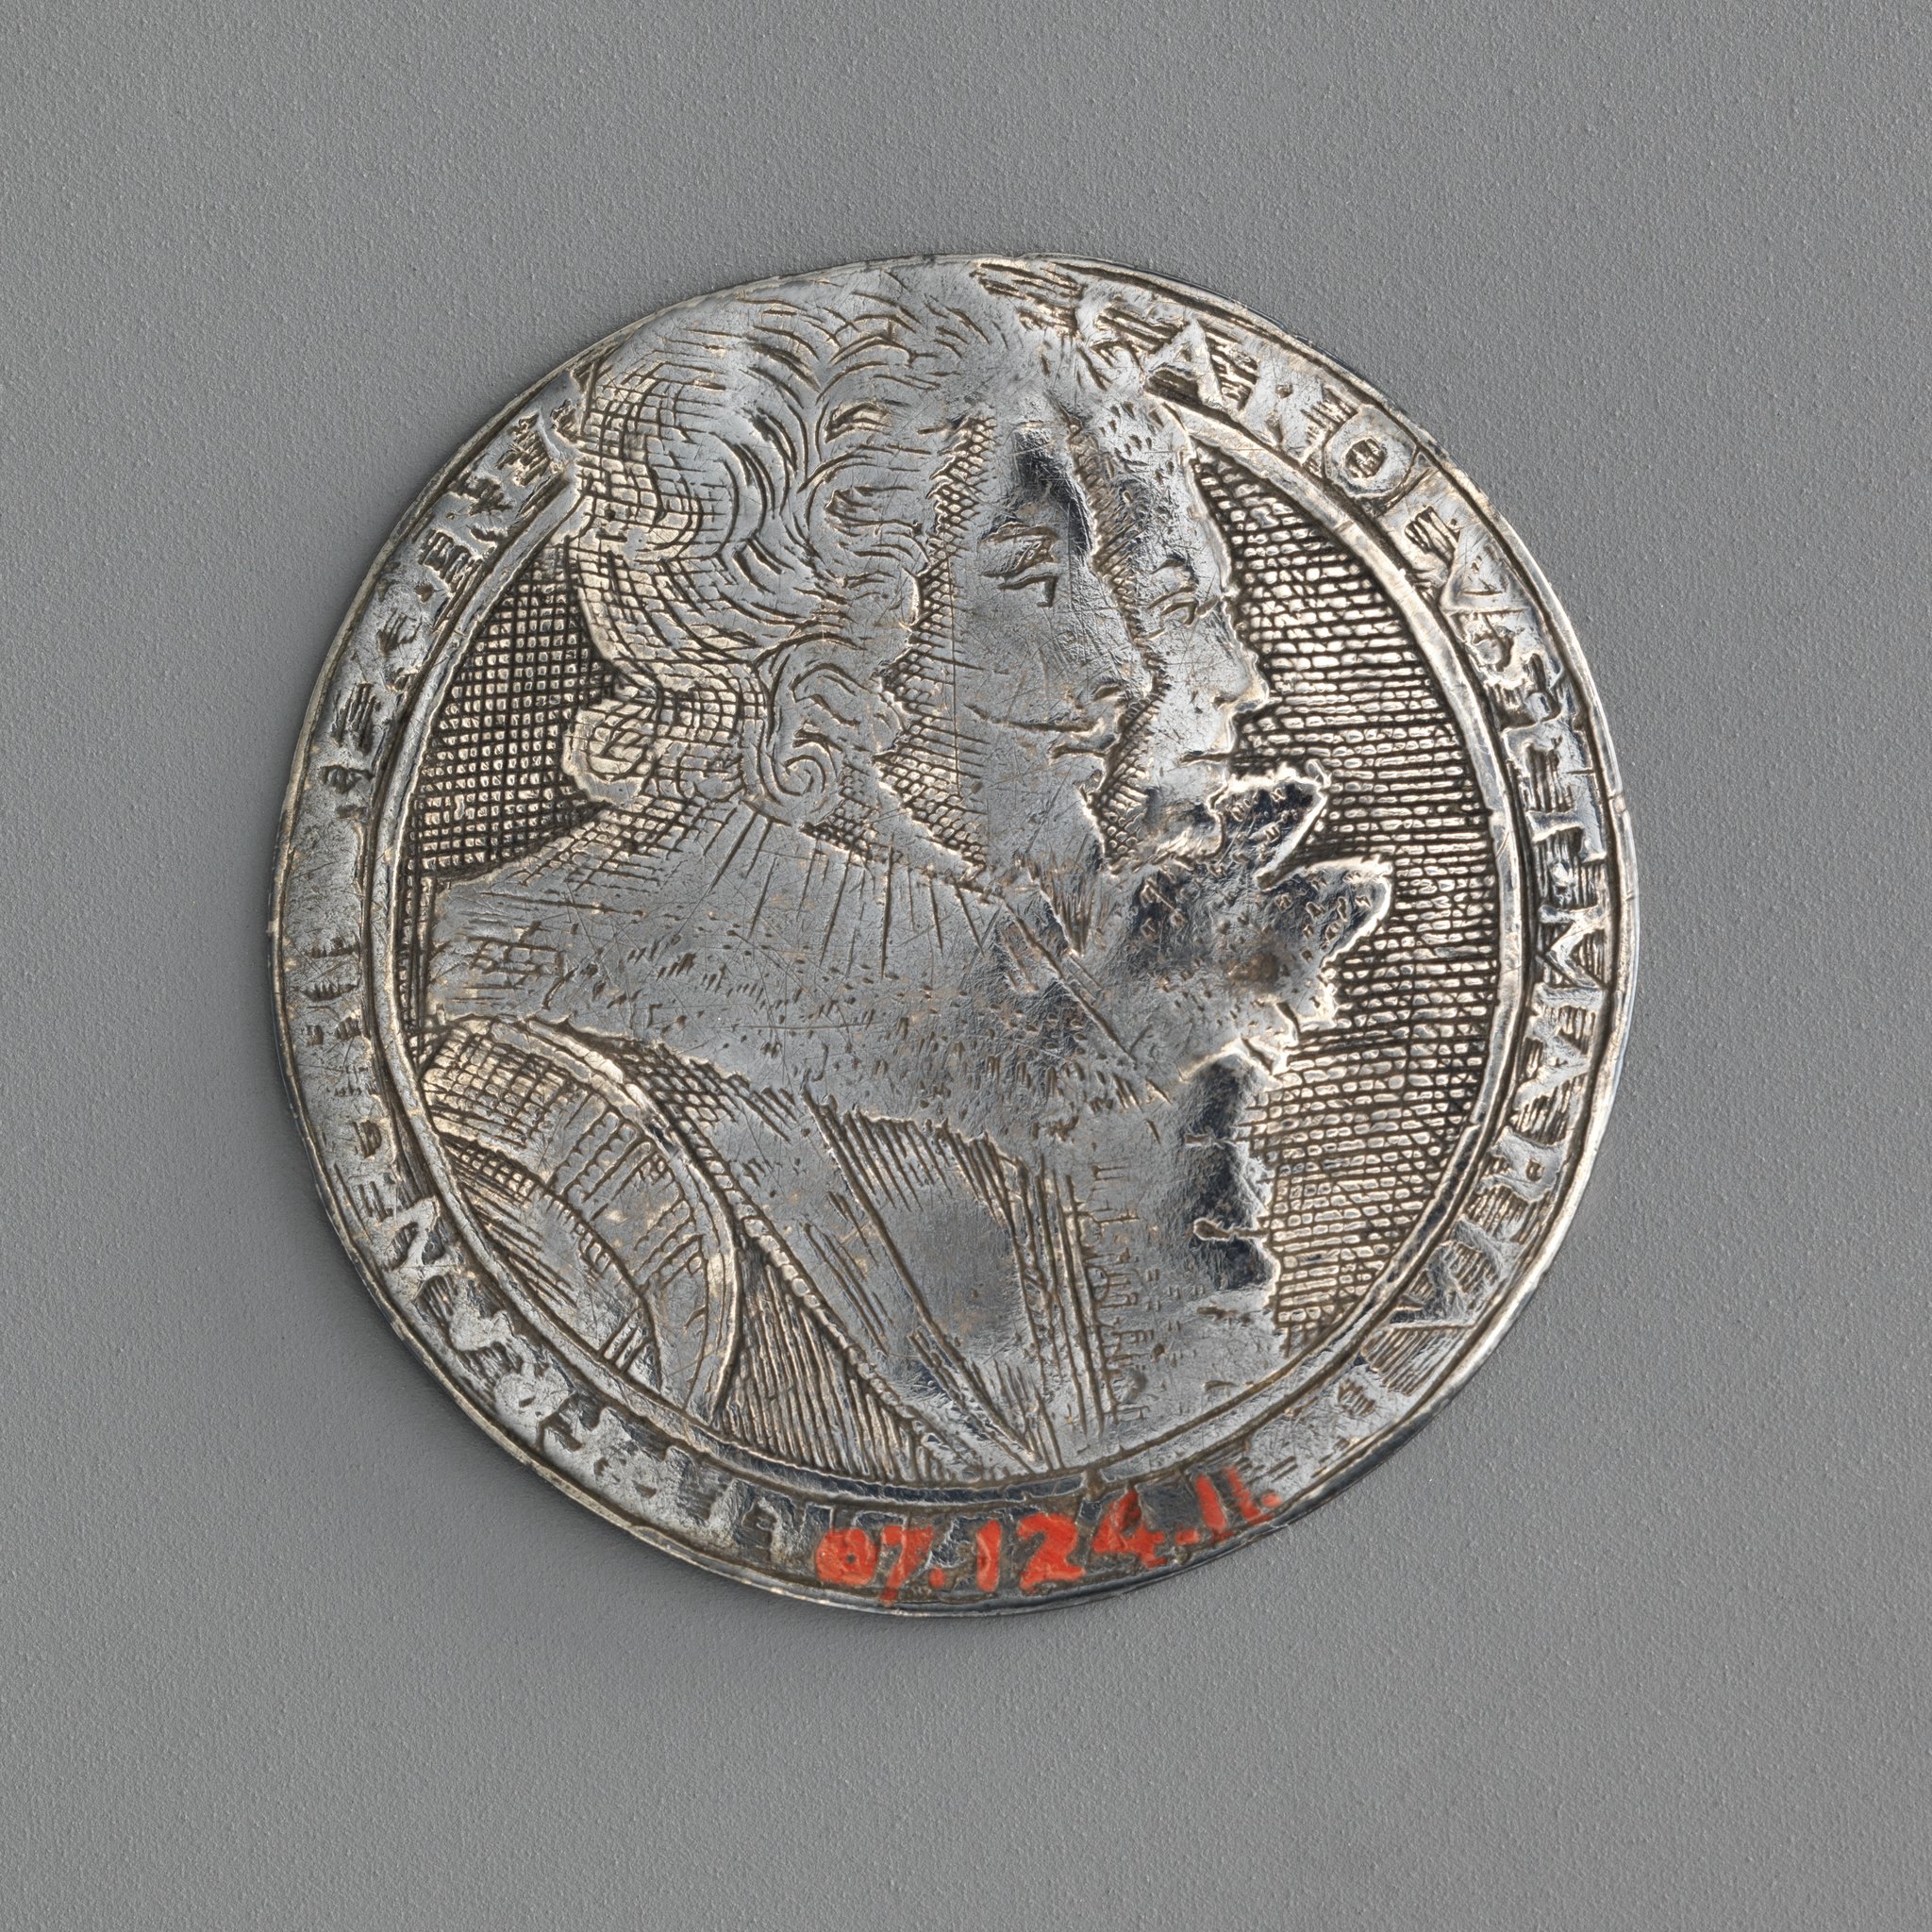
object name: counter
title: King Charles I and Queen Henrietta Maria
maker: simon de passe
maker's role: maker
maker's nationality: dutch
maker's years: 1590-1647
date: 1630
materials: silver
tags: kings,profiles